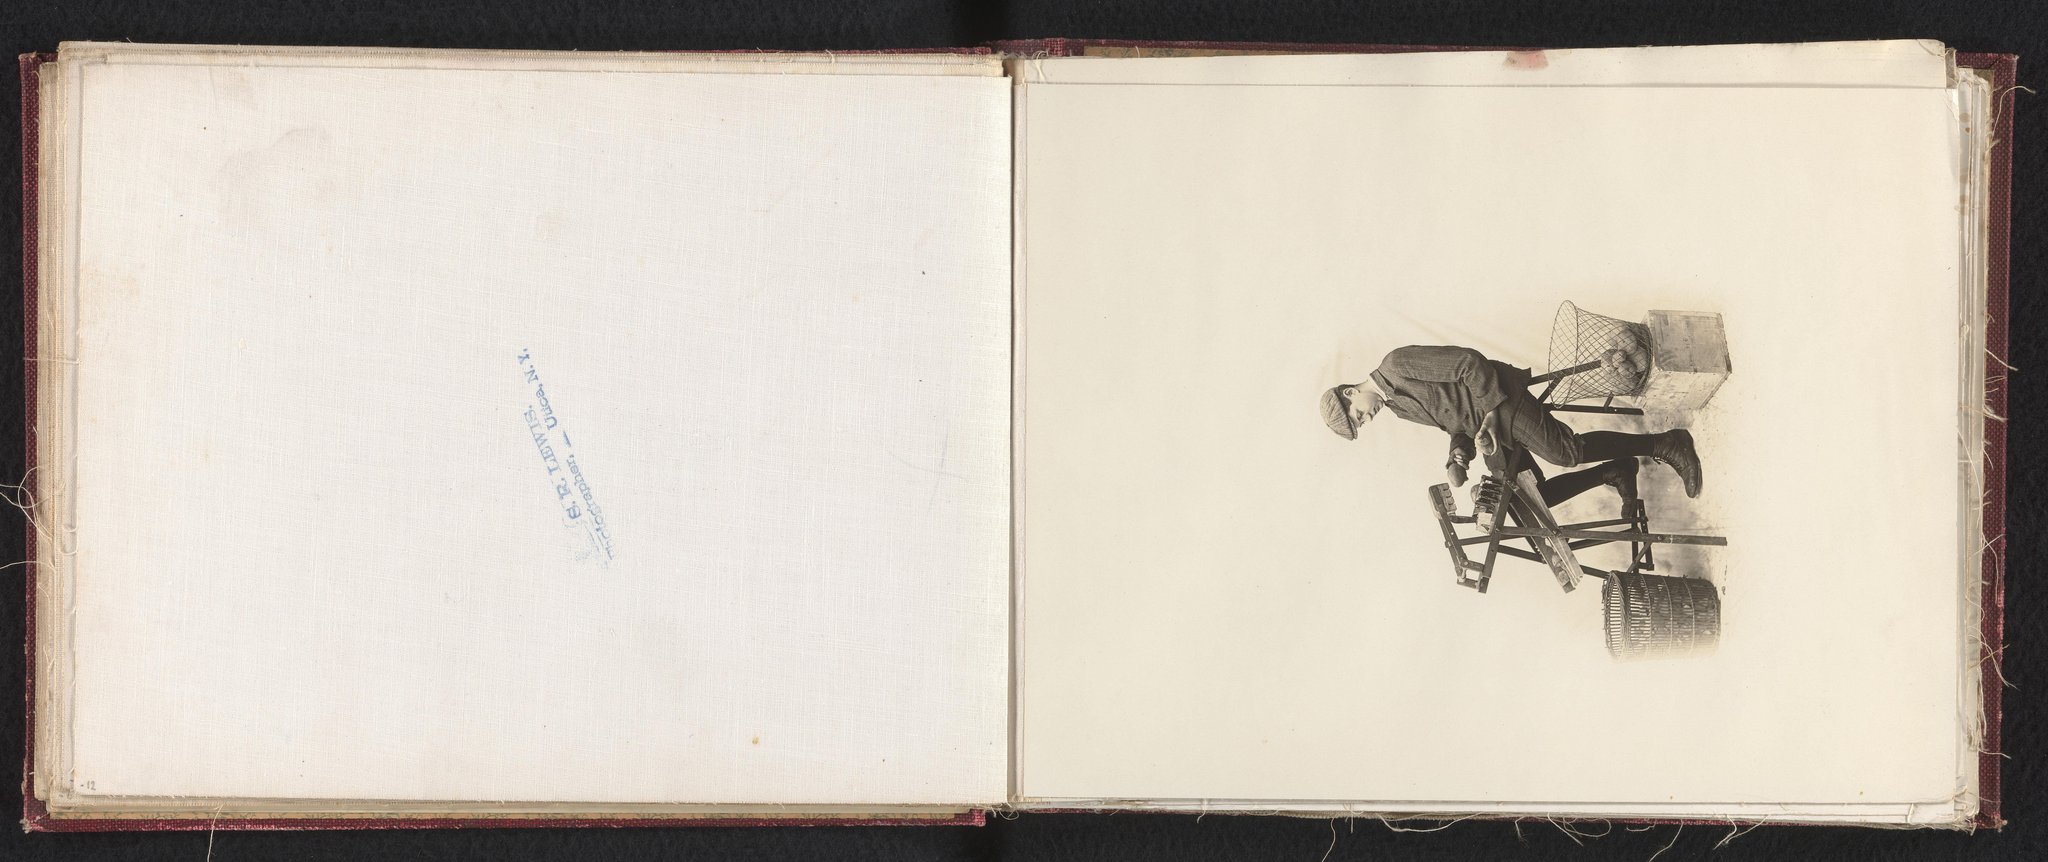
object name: page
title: Man met een landbouwwerktuig van de Eureka Mower Co. te Utrica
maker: lewis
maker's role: fotograaf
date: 1915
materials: paper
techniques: gelatin silver print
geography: utica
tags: agricultural implements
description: Foto op tiende ongenummerde pagina na voorplat.